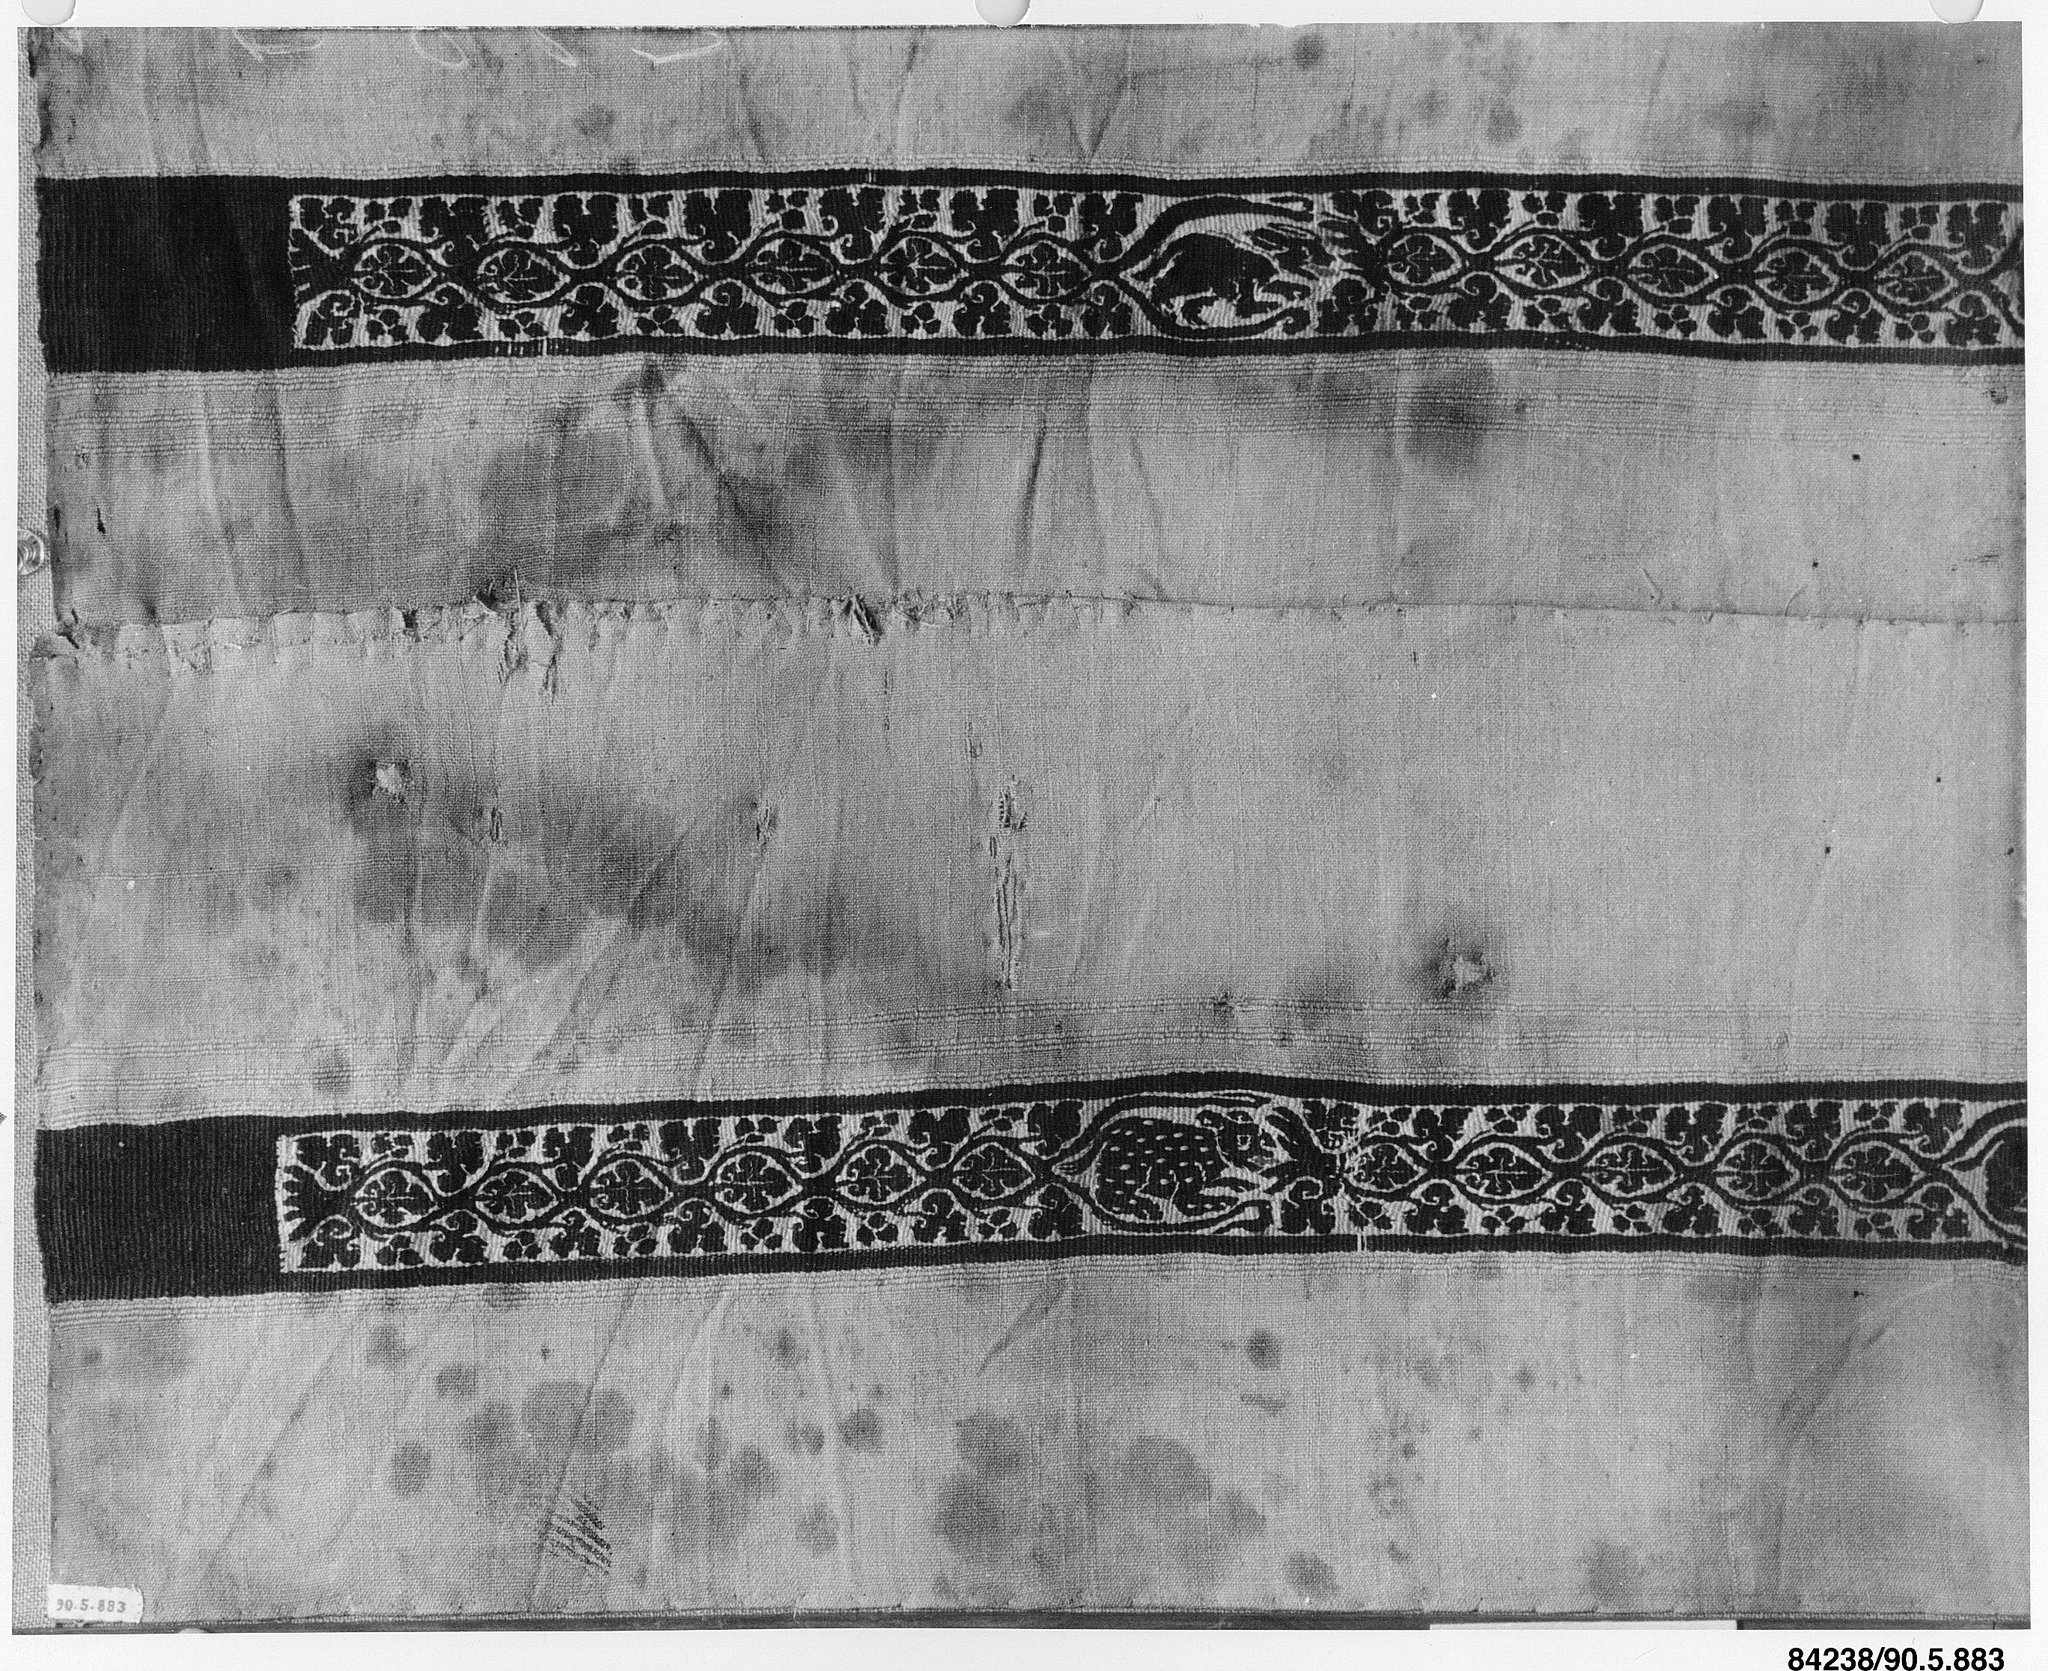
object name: tunic fragment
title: Fragment of a Tunic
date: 301-400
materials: linen, wool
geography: egypt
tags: animals